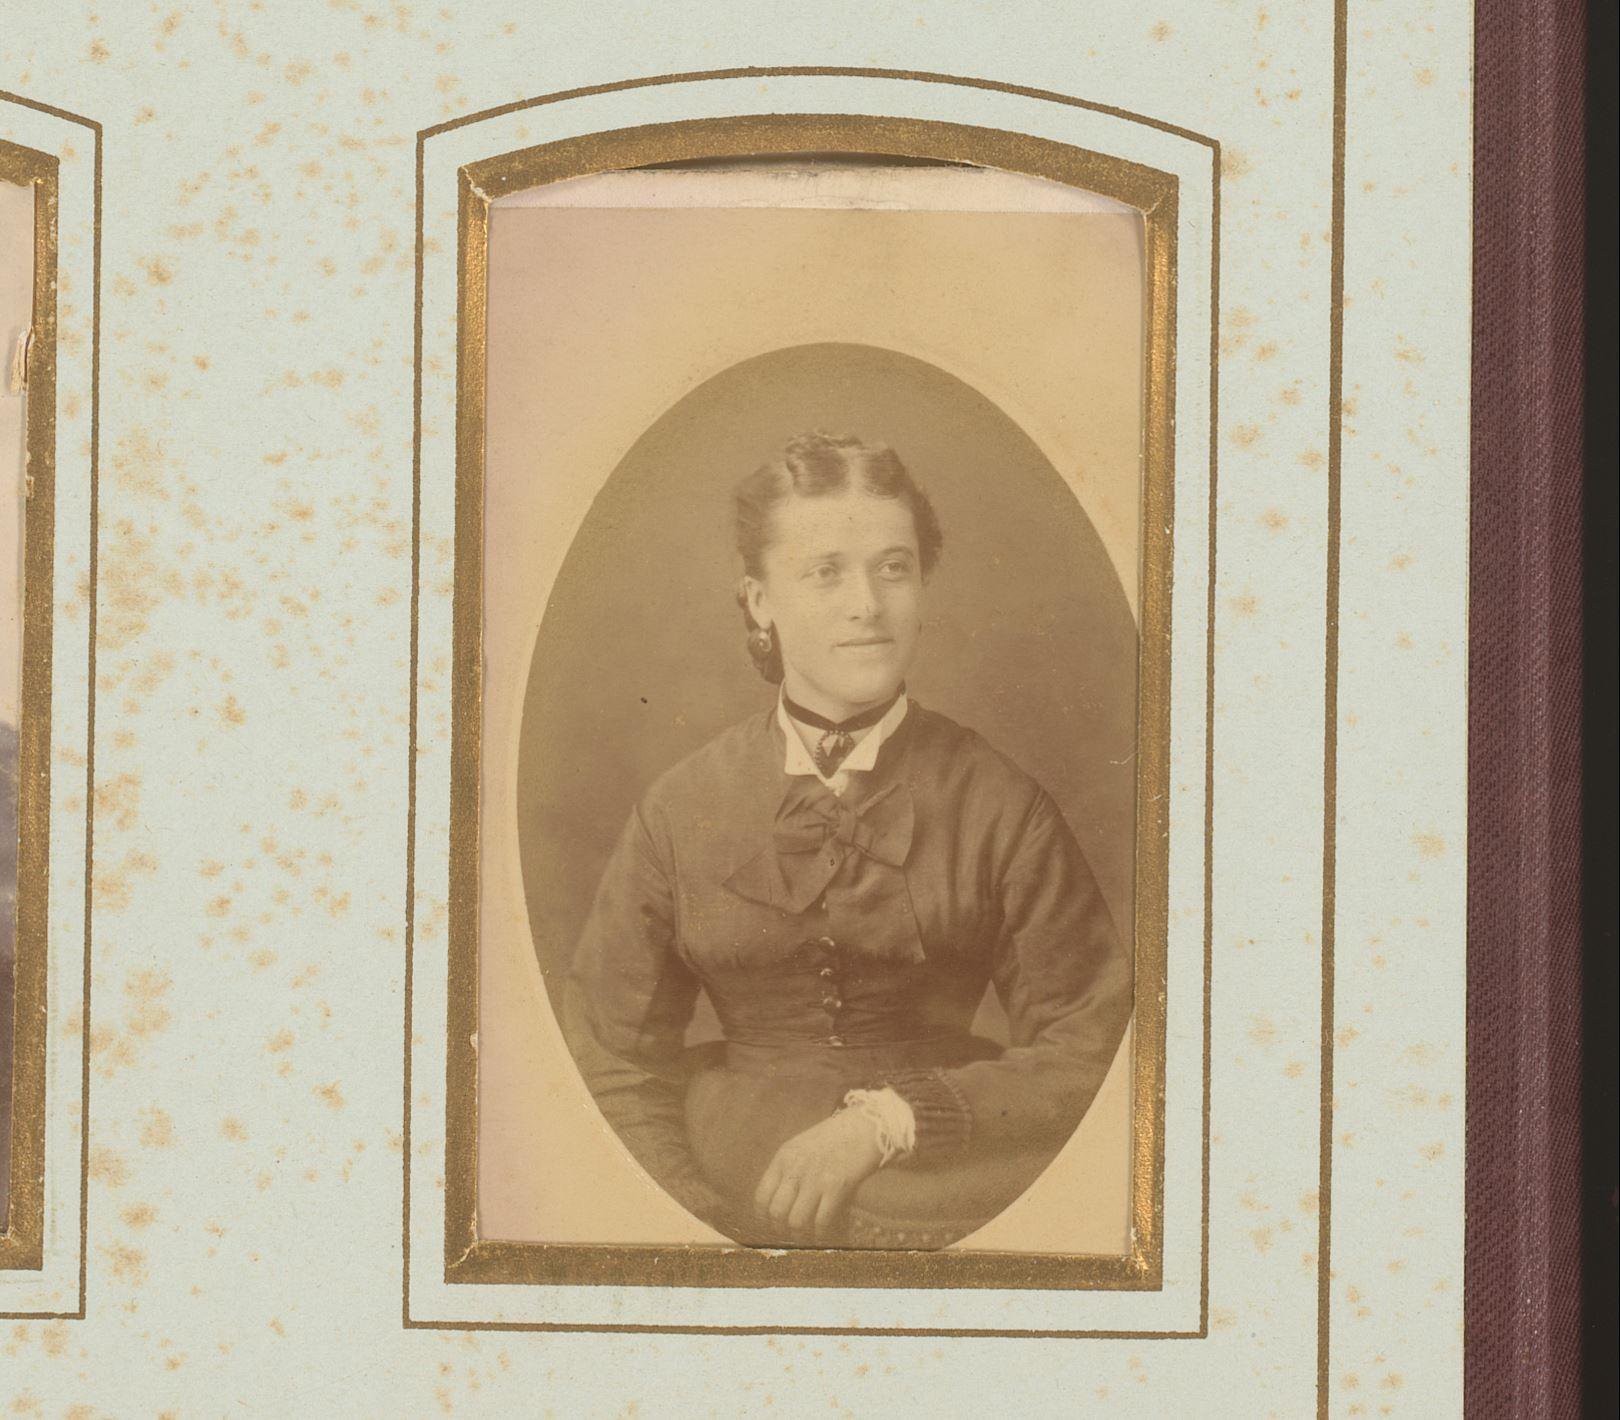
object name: album leaf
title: Portret van een jonge vrouw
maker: Anonymous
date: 1880-1900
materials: cardboard, photographic support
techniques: albumen print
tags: girl (child between toddler and youth)